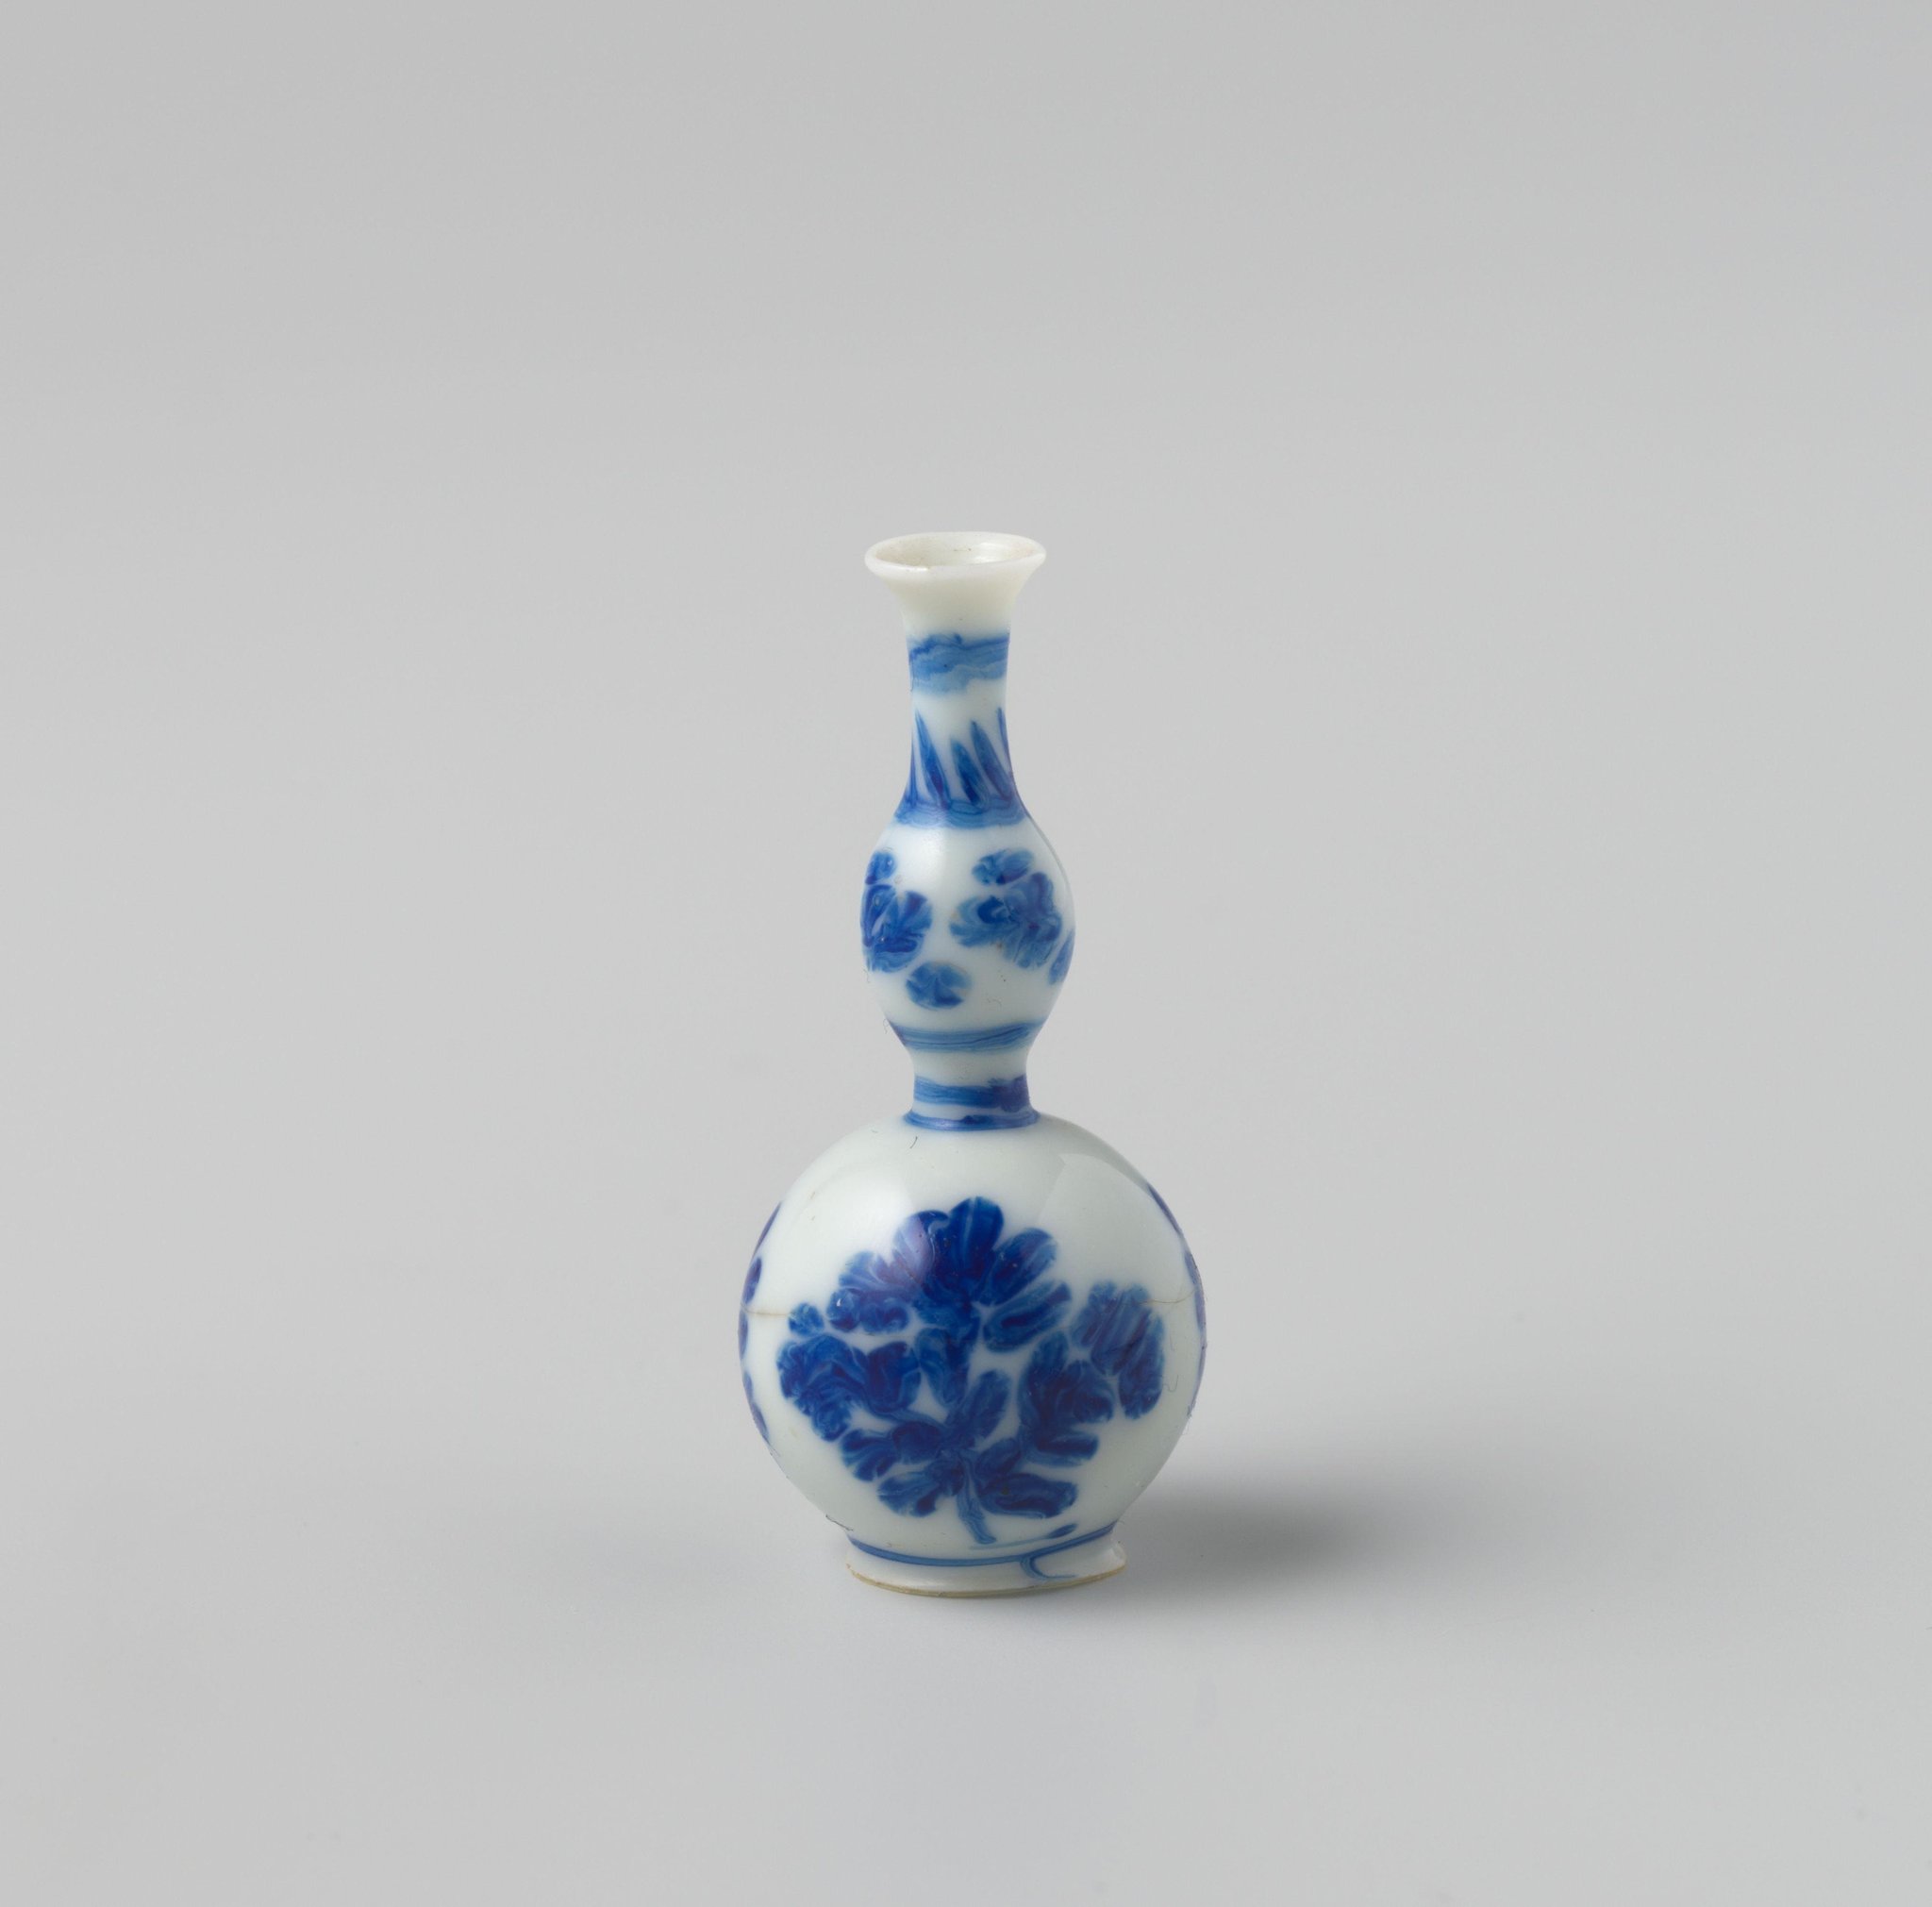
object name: bottle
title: Fles van melkglas met blauwe emailverf beschildering, imitatie Chinees porselein; model knobbelfles op standring, met bloem tuilen op buik en bolvormige verdikking van hals.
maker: Anonymous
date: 1675-1710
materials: glass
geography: amsterdam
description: Fles van melkglas met blauwe emailverf beschildering, imitatie Chinees blauw porselein; model knobbelfles op standring, met bloemtuilen op buik en bolvormige verdikking van de hals.